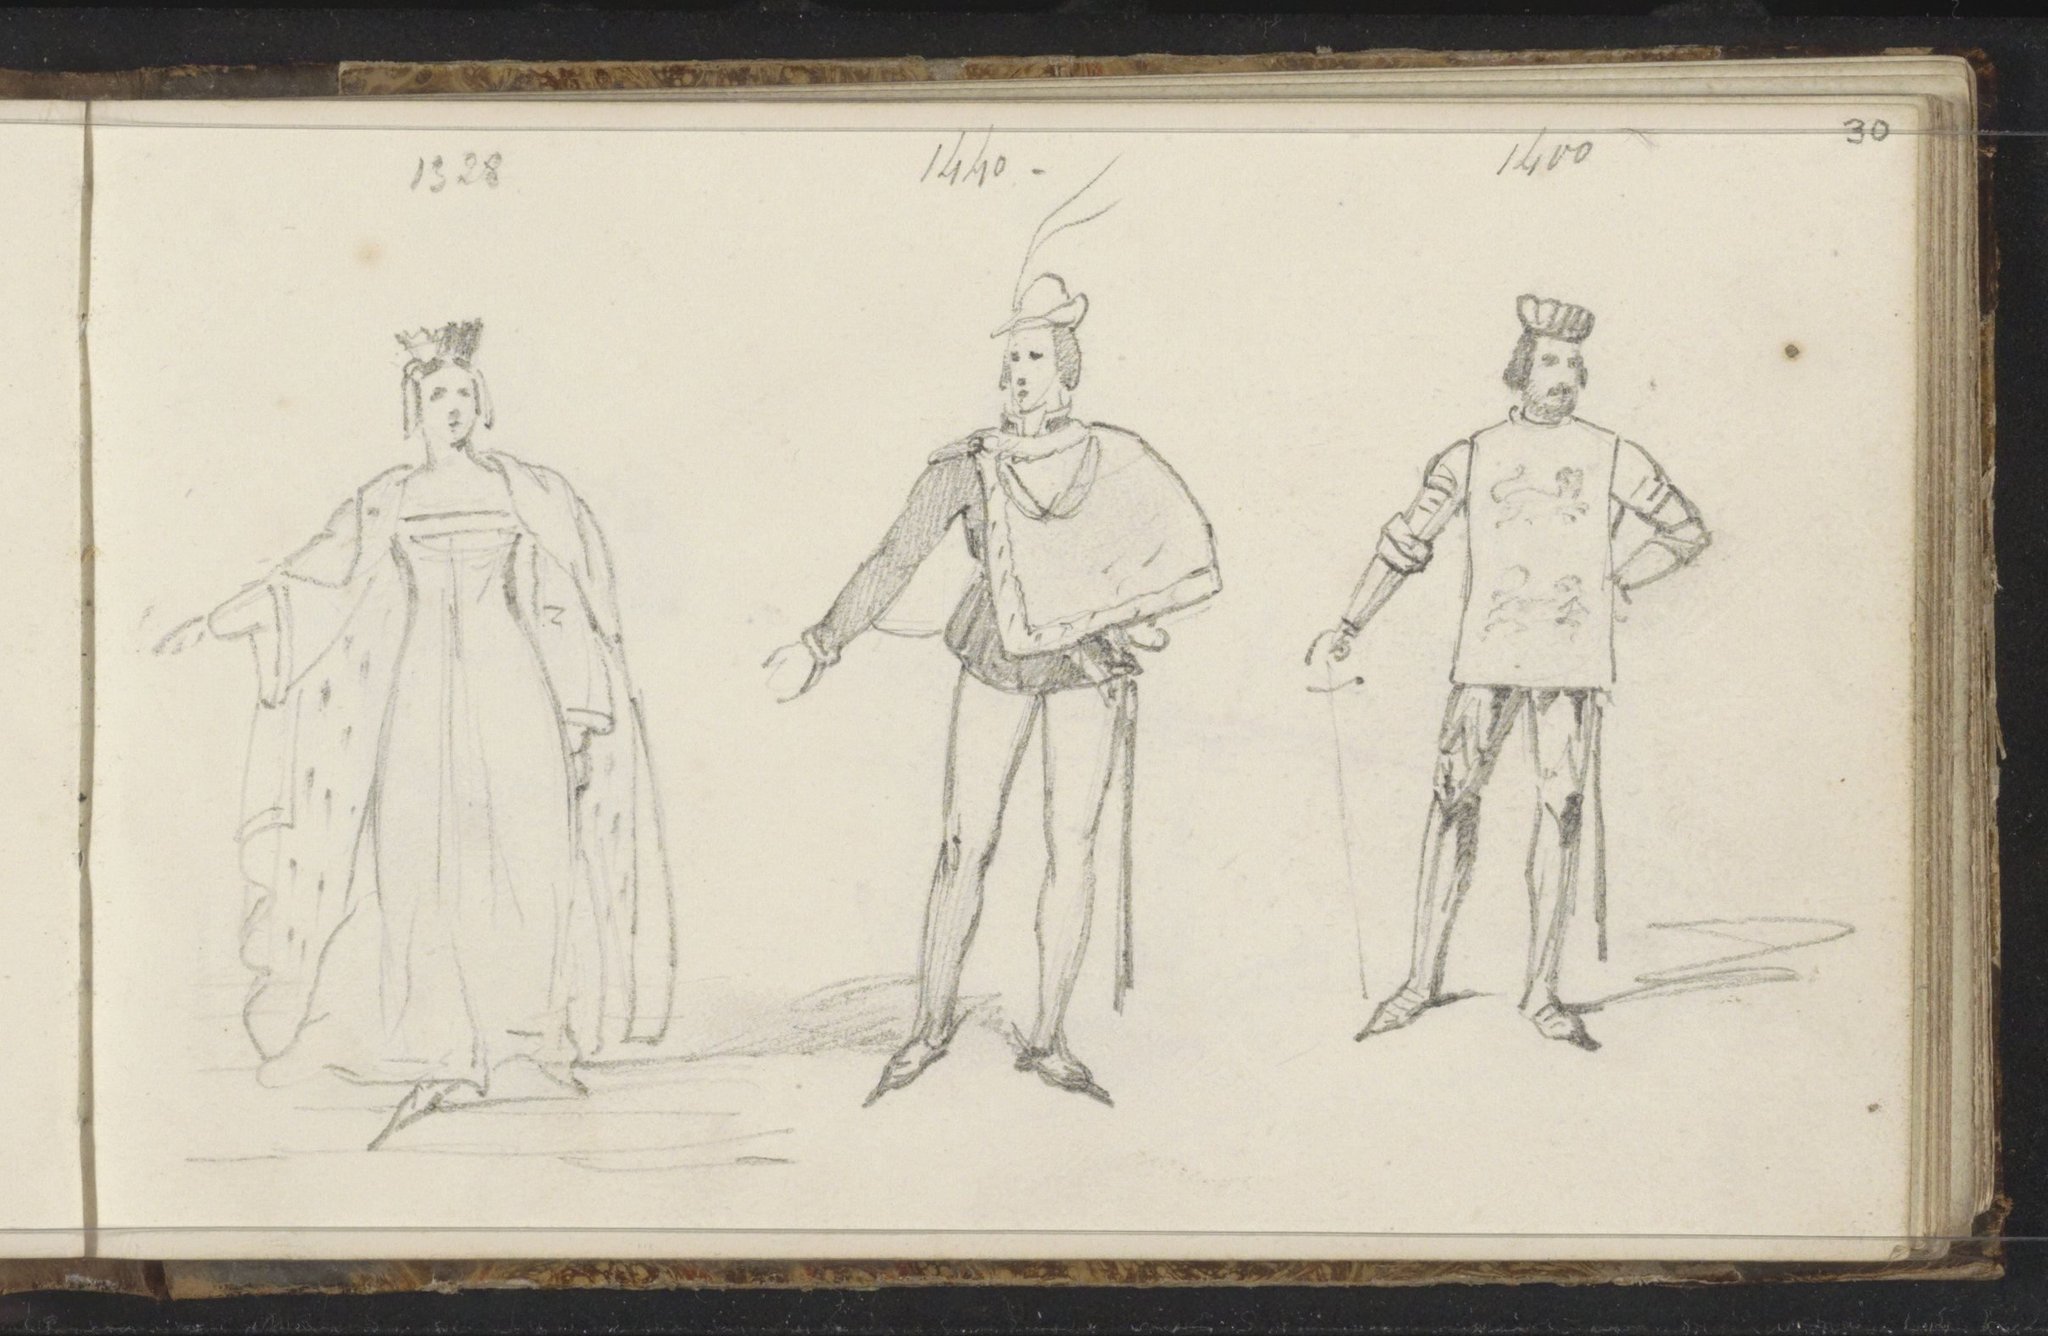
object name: sketchbook leaf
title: Vrouw en twee mannen in middeleeuws kostuum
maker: willem hendrik schmidt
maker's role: draughtsman, painter, print maker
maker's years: 1809-1849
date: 1819-1849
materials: paper, pencil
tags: historical costume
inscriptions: annotation: ‘1328 1440 1400’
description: Blad 30 recto uit een schetsboek met 60 bladen.